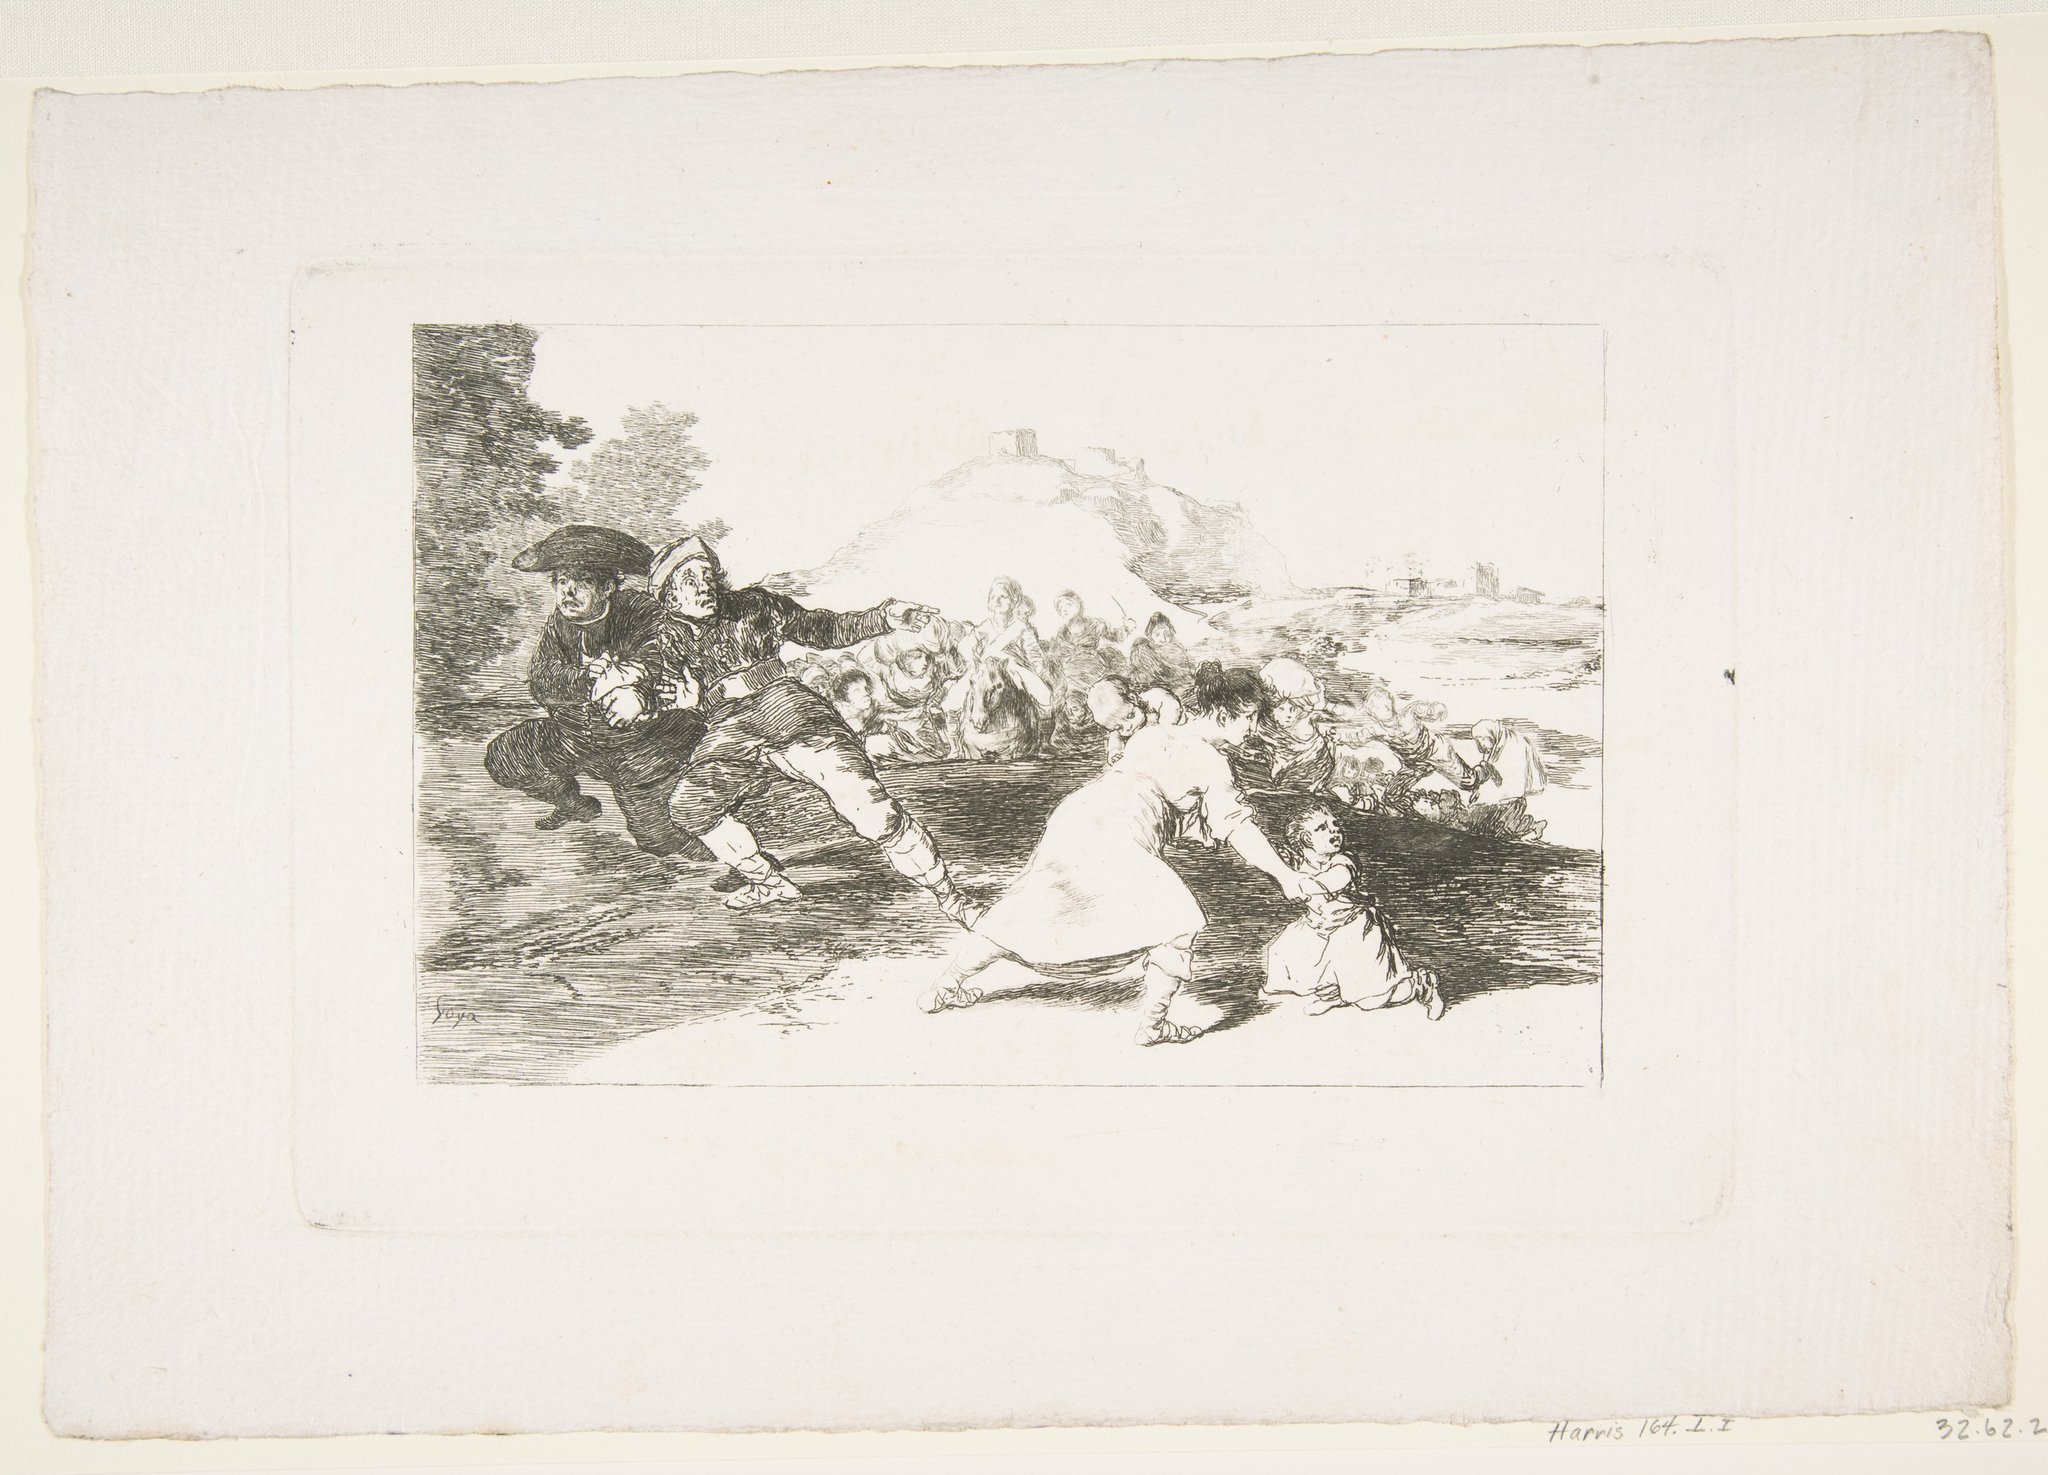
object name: print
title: Plate 44 from "The Disasters of War" (Los Desastres de la Guerra): 'I saw it' (Yo lo vi)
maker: goya (francisco de goya y lucientes)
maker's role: artist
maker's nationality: spanish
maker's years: 1746-1828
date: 1810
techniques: engraving, drypoint, etching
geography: spain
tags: fear,children,men,women